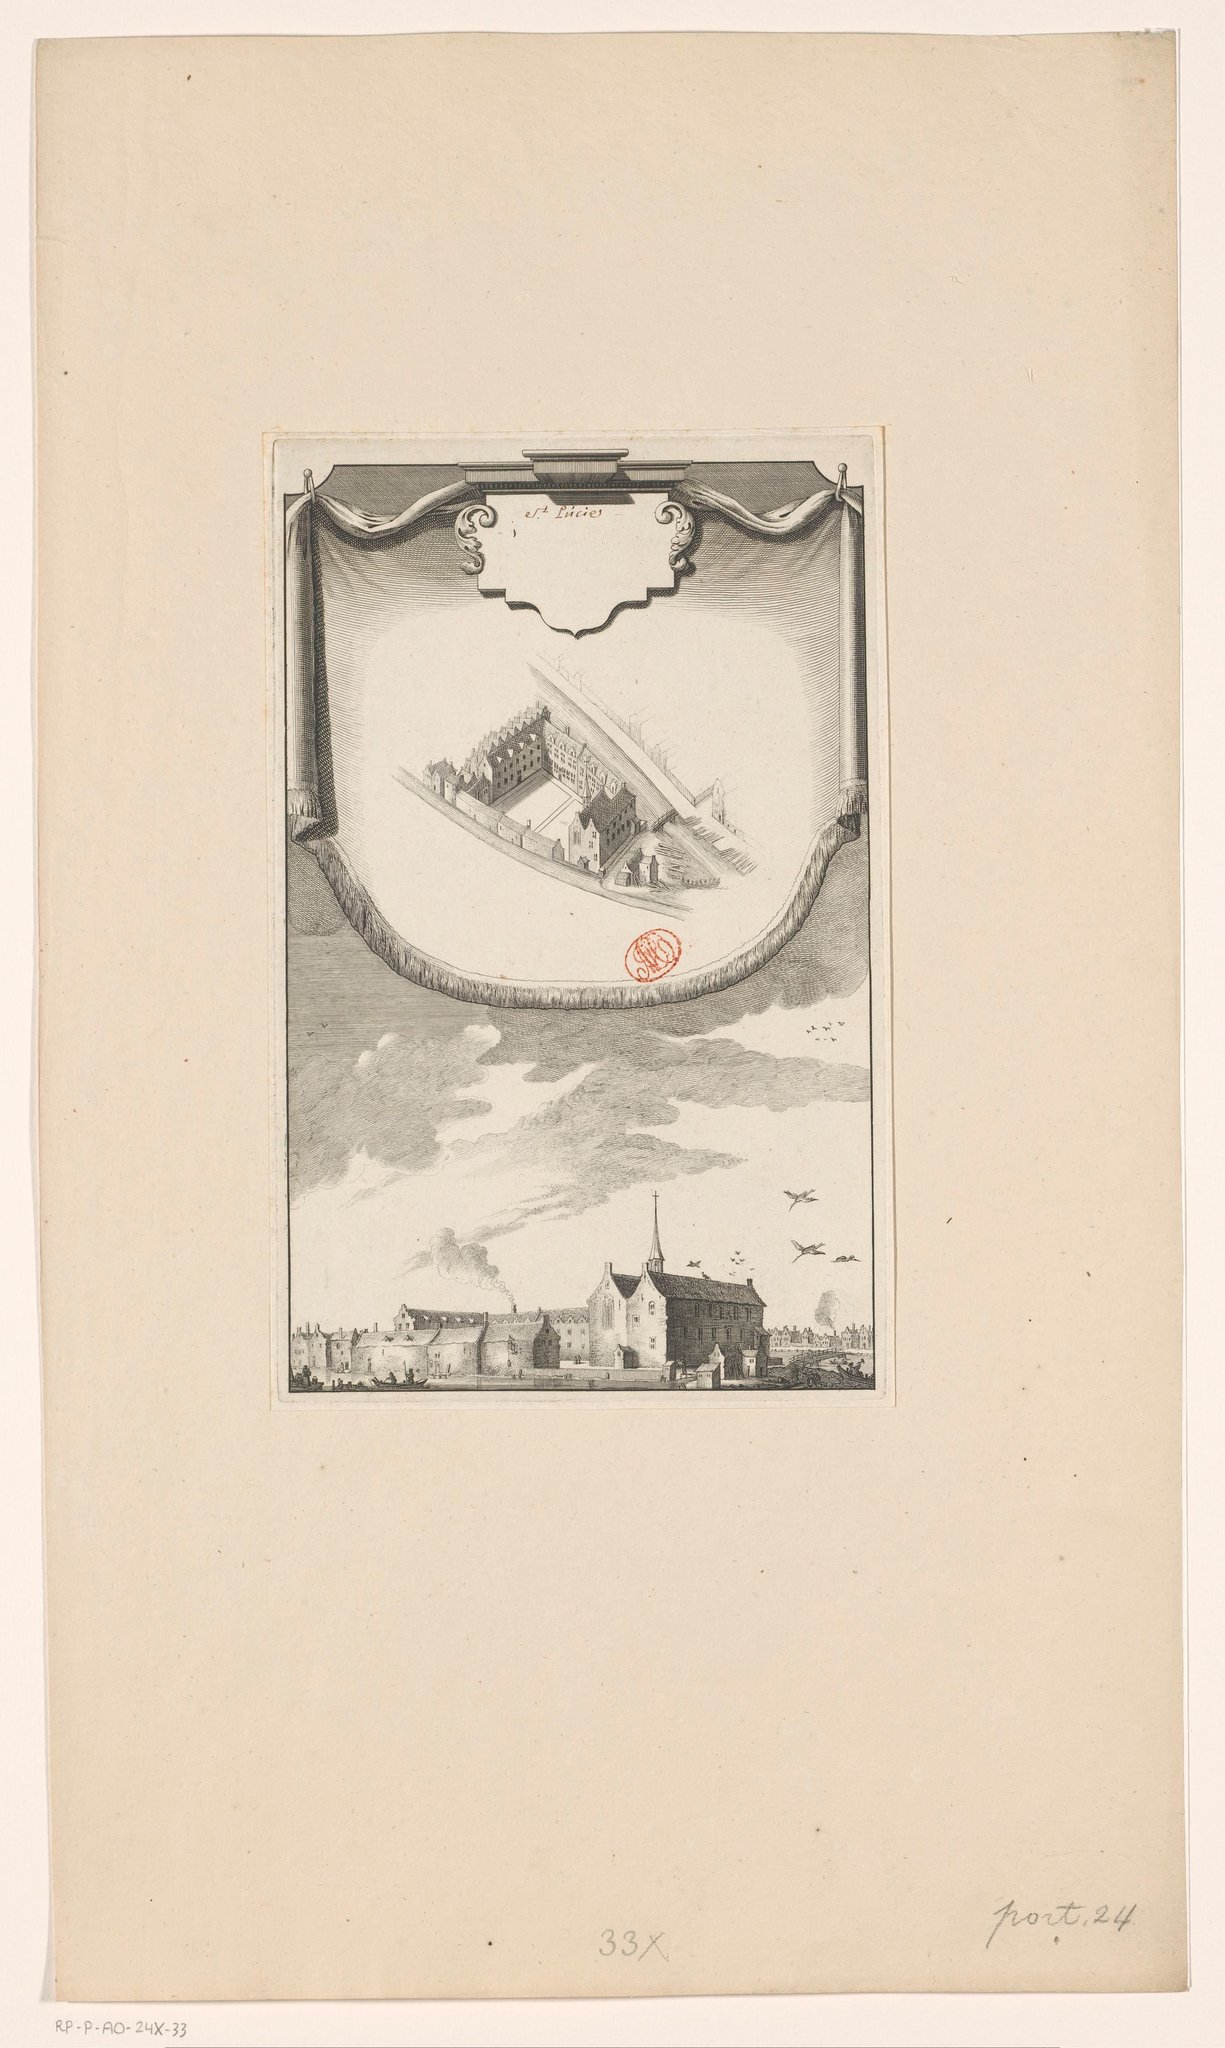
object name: print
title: Gezichten op het Sint-Luciënklooster te Amsterdam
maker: Anonymous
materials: ink, paper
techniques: engraving, etching, pen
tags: abbey, monastery, convent ~ roman catholic church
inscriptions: collector's mark: Lugt 195, inscription: ‘St. Lucies’, collector's mark: Lugt 2233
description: Latere staat van prent ook gebruikt in: Wagenaar, Jan. Amsterdam, in zyne opkomst, aanwas, geschiedenissen (…). 3 delen [folio-uitgave]. Amsterdam: Isaak Tirion en Yntema & Tieboel, 1760-1767, dl. 1 (Isaac Tirion, 1760). Zie RP-P-AO-24X-32 voor tweede staat. Dat de prent de situatie rond 1544 weergeeft gaat terug op het feit dat voor het maken van deze en andere prenten van kloosters en kerken van voor de Alteratie (1578) is uitgegaan van de plattegrond van Cornelis Anthonisz. uit 1544 (zie RP-P-OB-70.399 en RP-P-AO-20-15).